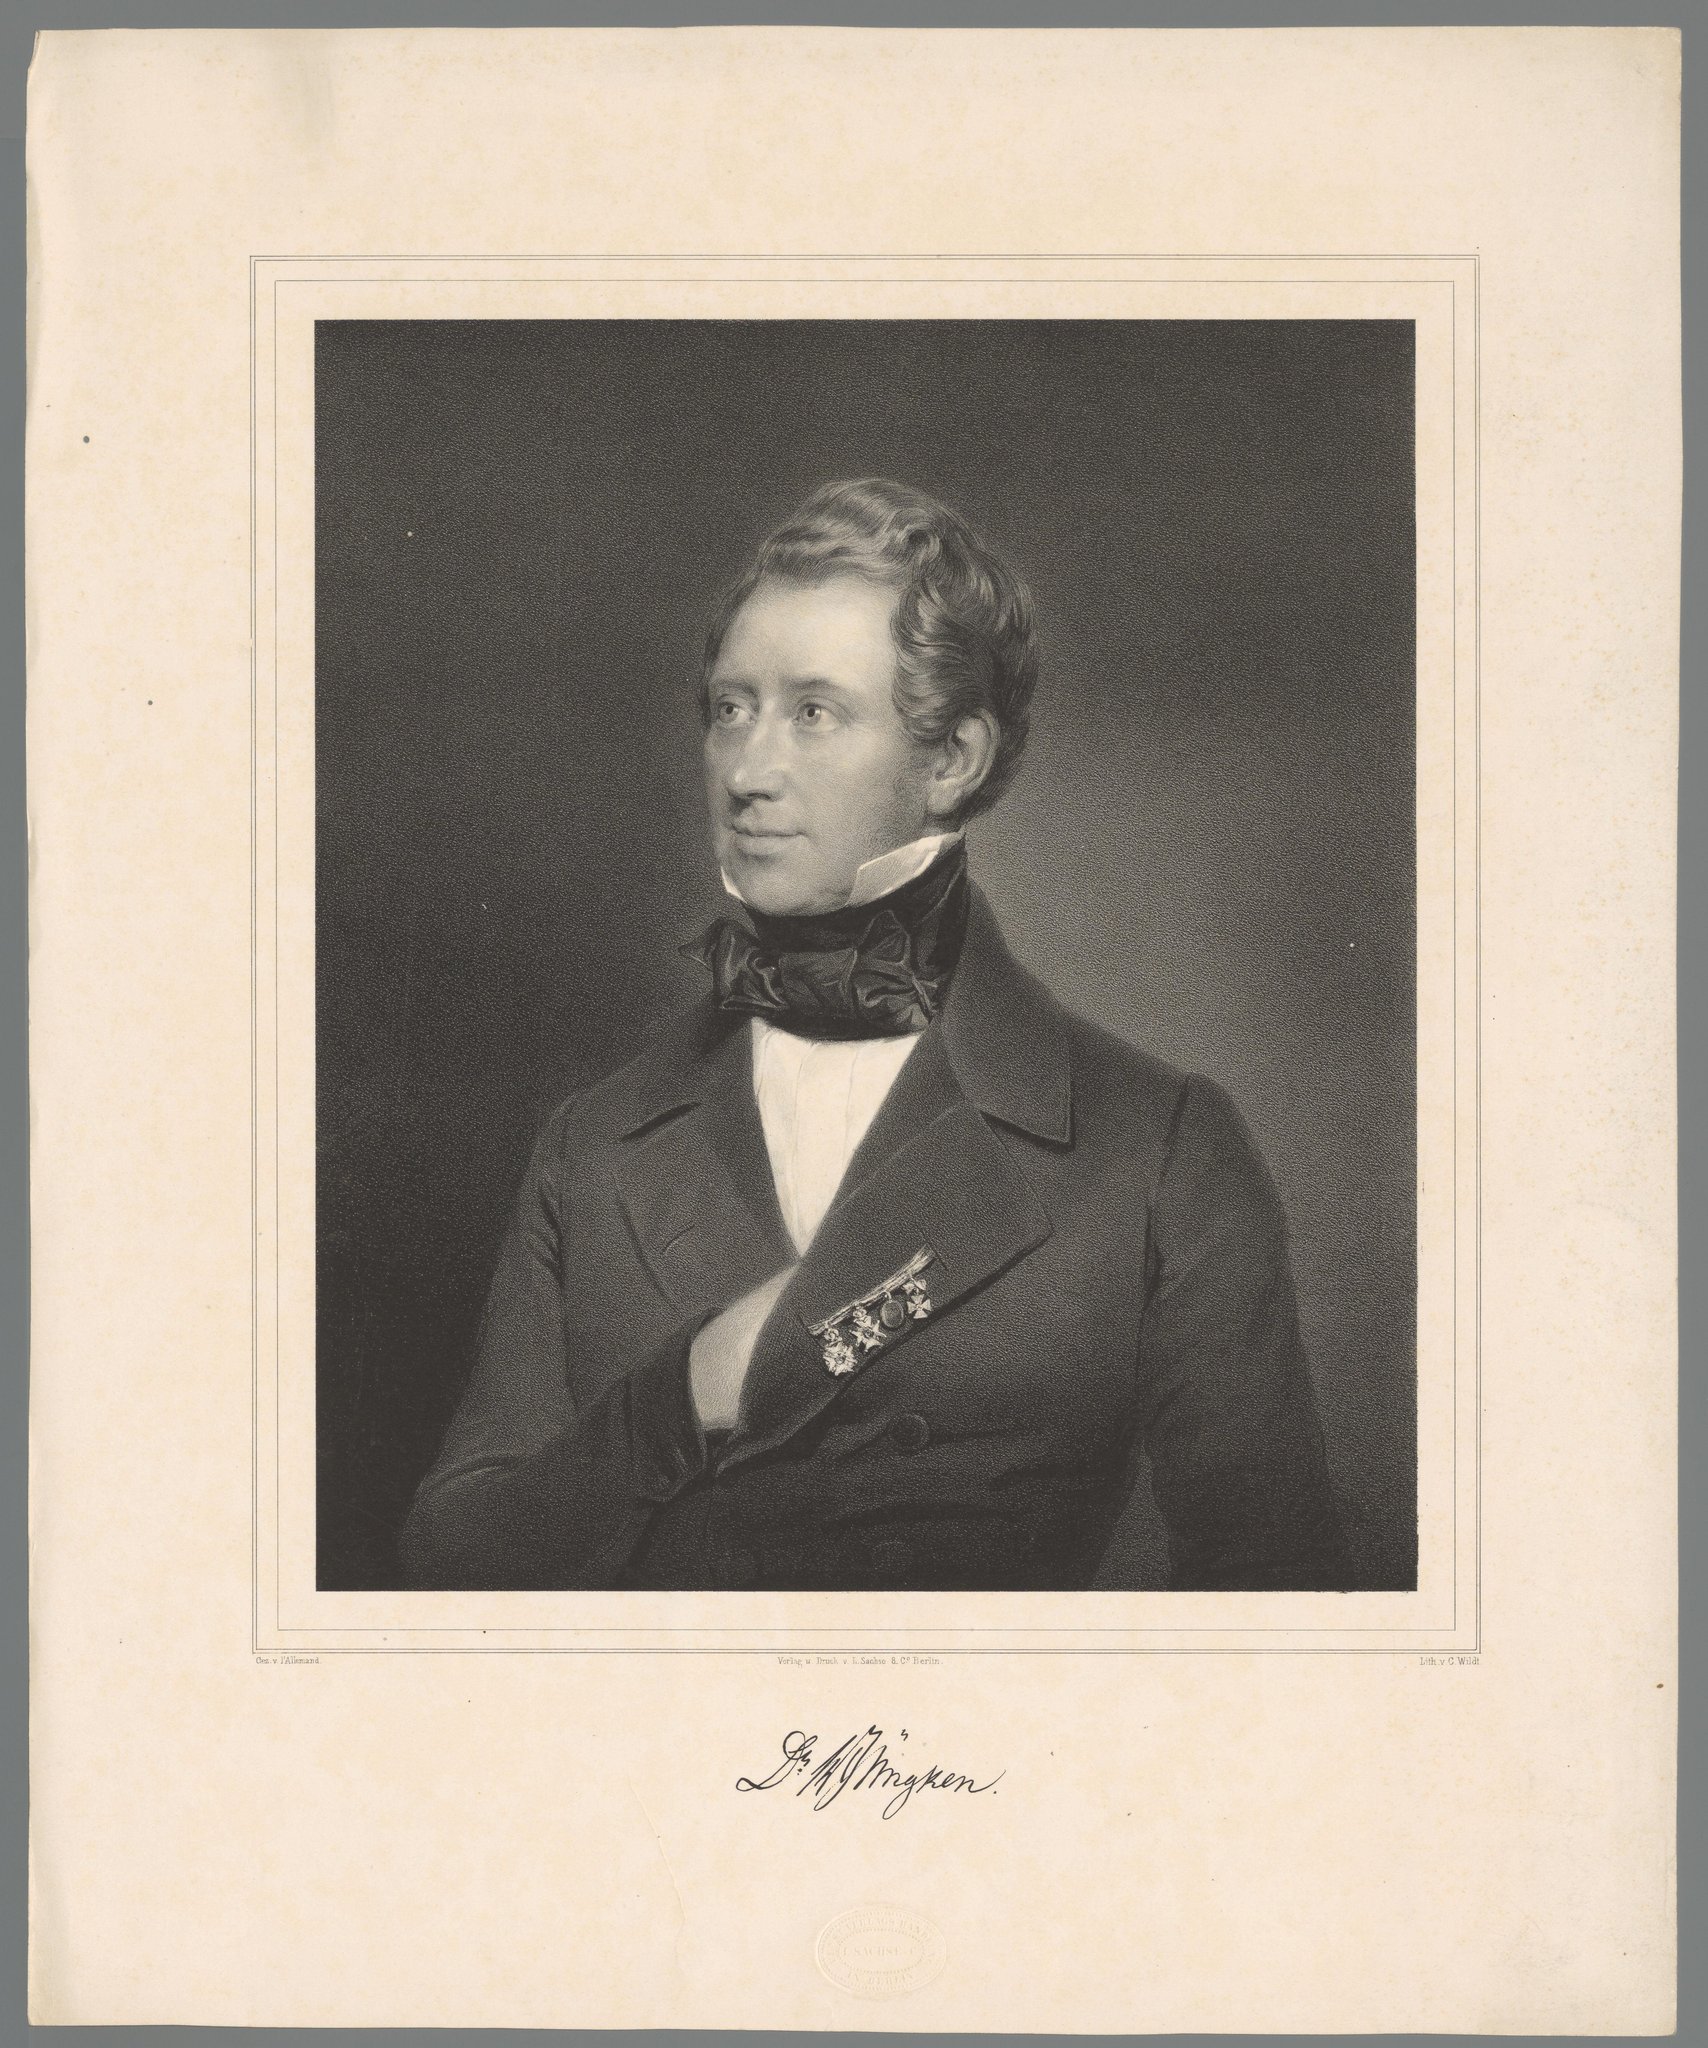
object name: print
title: Portret van Johann Christian Jüngken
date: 1832-1854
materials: paper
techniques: lithograph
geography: berlin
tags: historical persons, barber; surgeon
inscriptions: check stamp: Lugt 5005, collector's mark: Lugt 2228